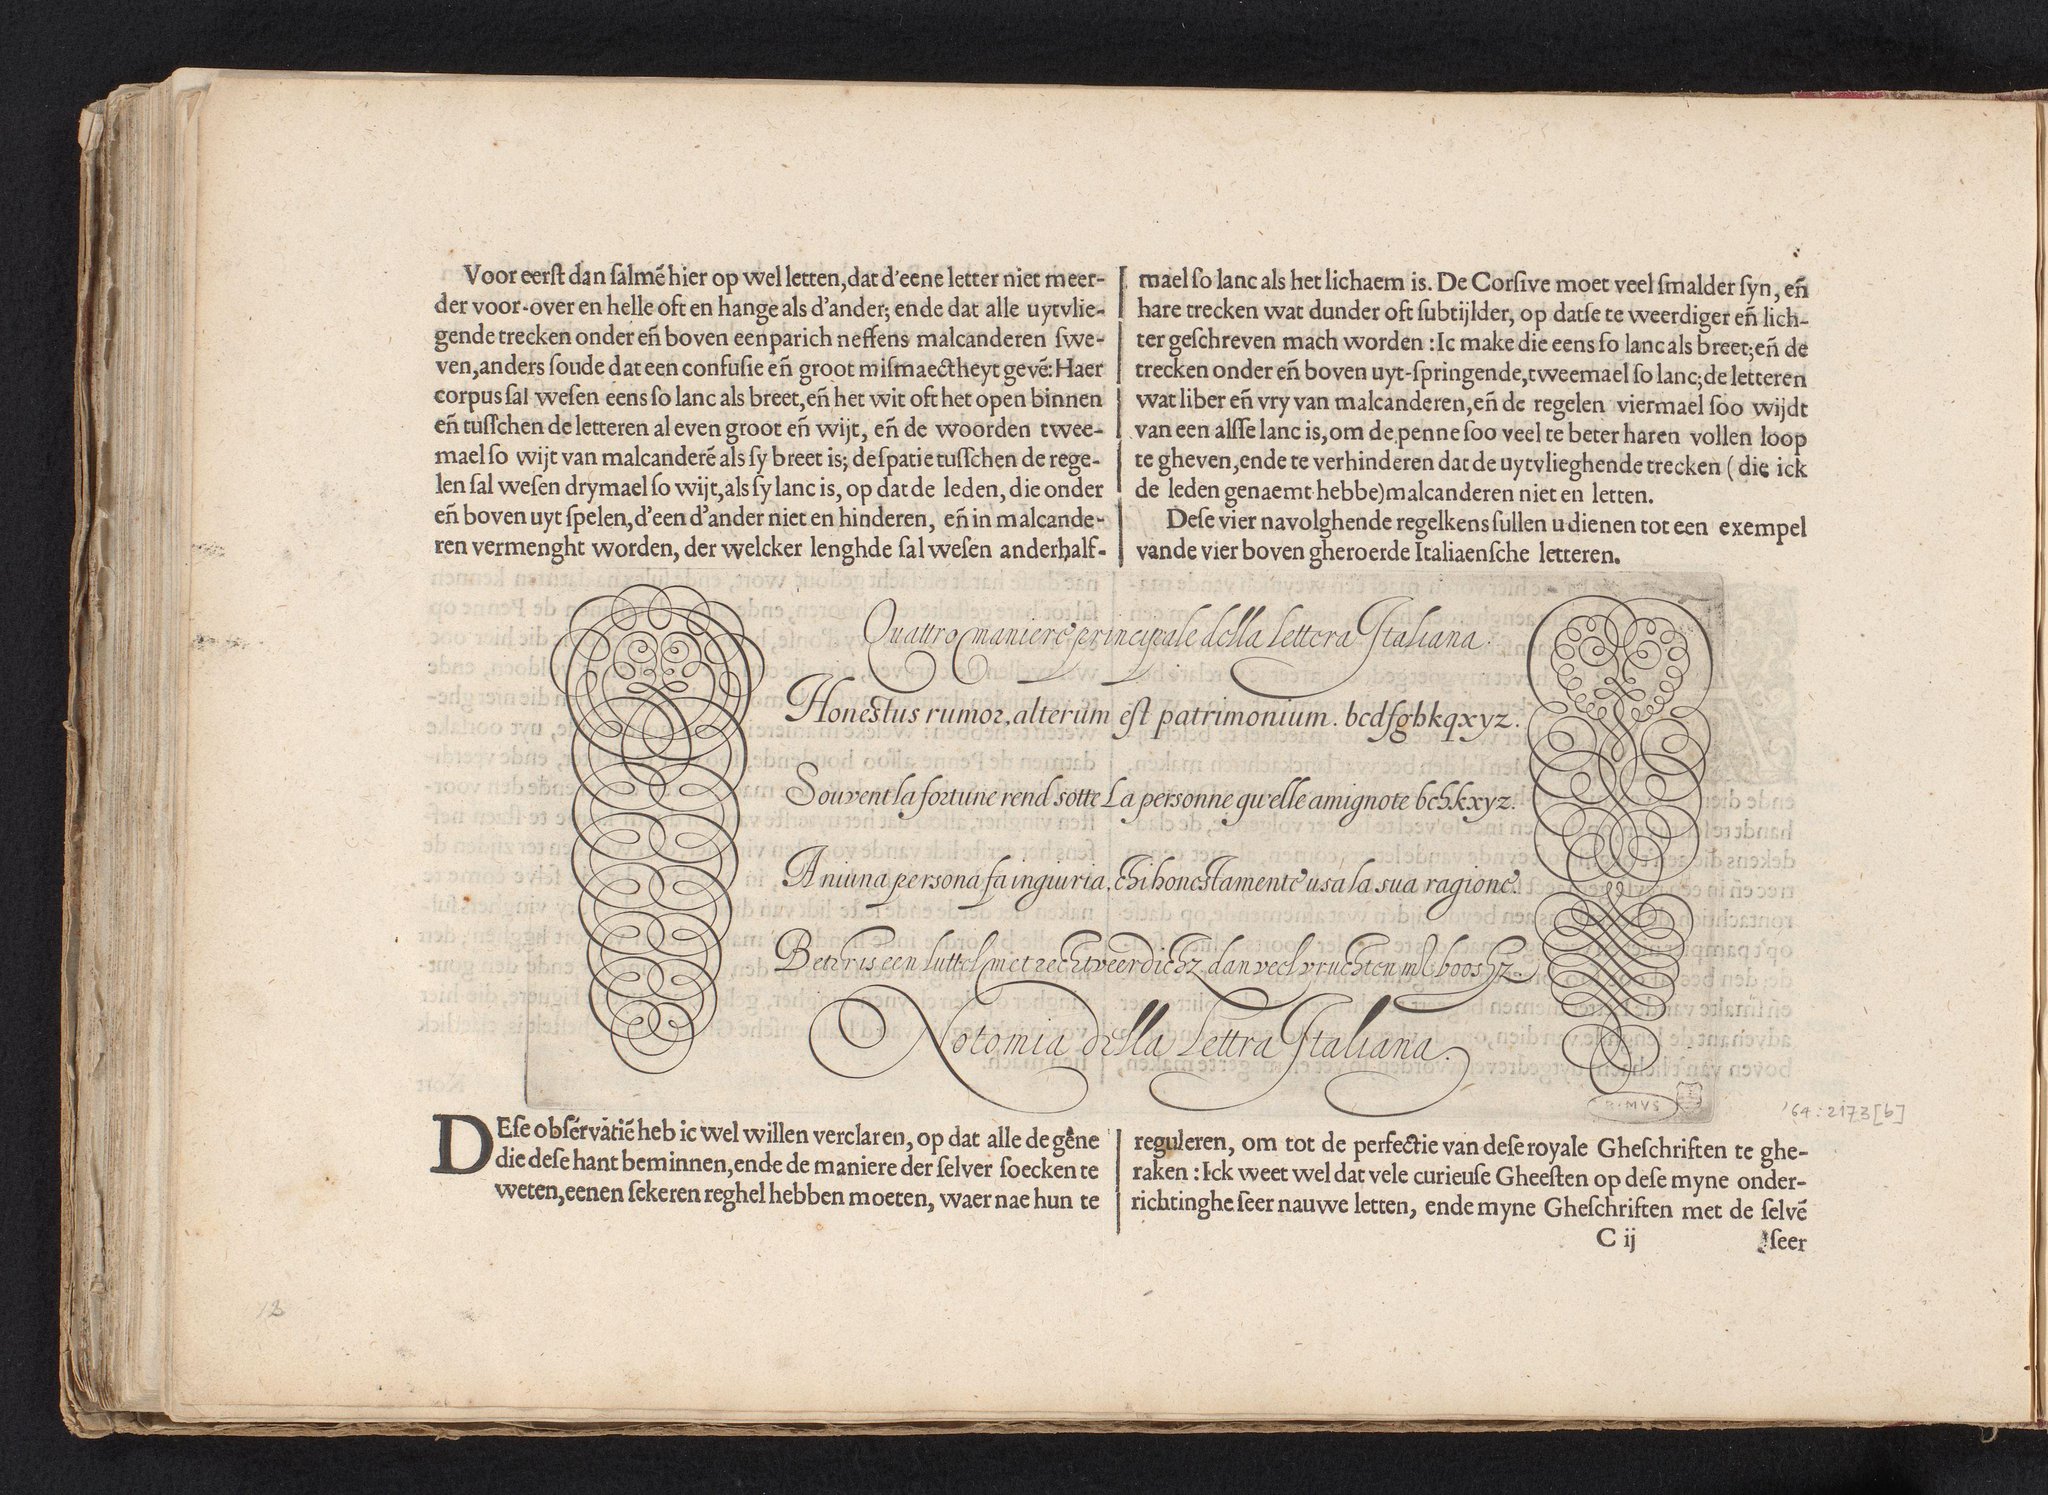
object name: text sheet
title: Beschrijvinghe vande Italiaensche Letter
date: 1605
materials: paper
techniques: engraving, letterpress printing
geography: amsterdam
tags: calligraphy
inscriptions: collector's mark: Lugt 2760, collector's mark: Lugt 2228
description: Folio C2r met een vervolg van de beschrijving van de Italiaanse letteren en een schrijfvoorbeeld met vier regels tekst in vier handen, getiteld: Quattro maniere principale della lettera Italiana. Het blad maakt deel uit van een album.